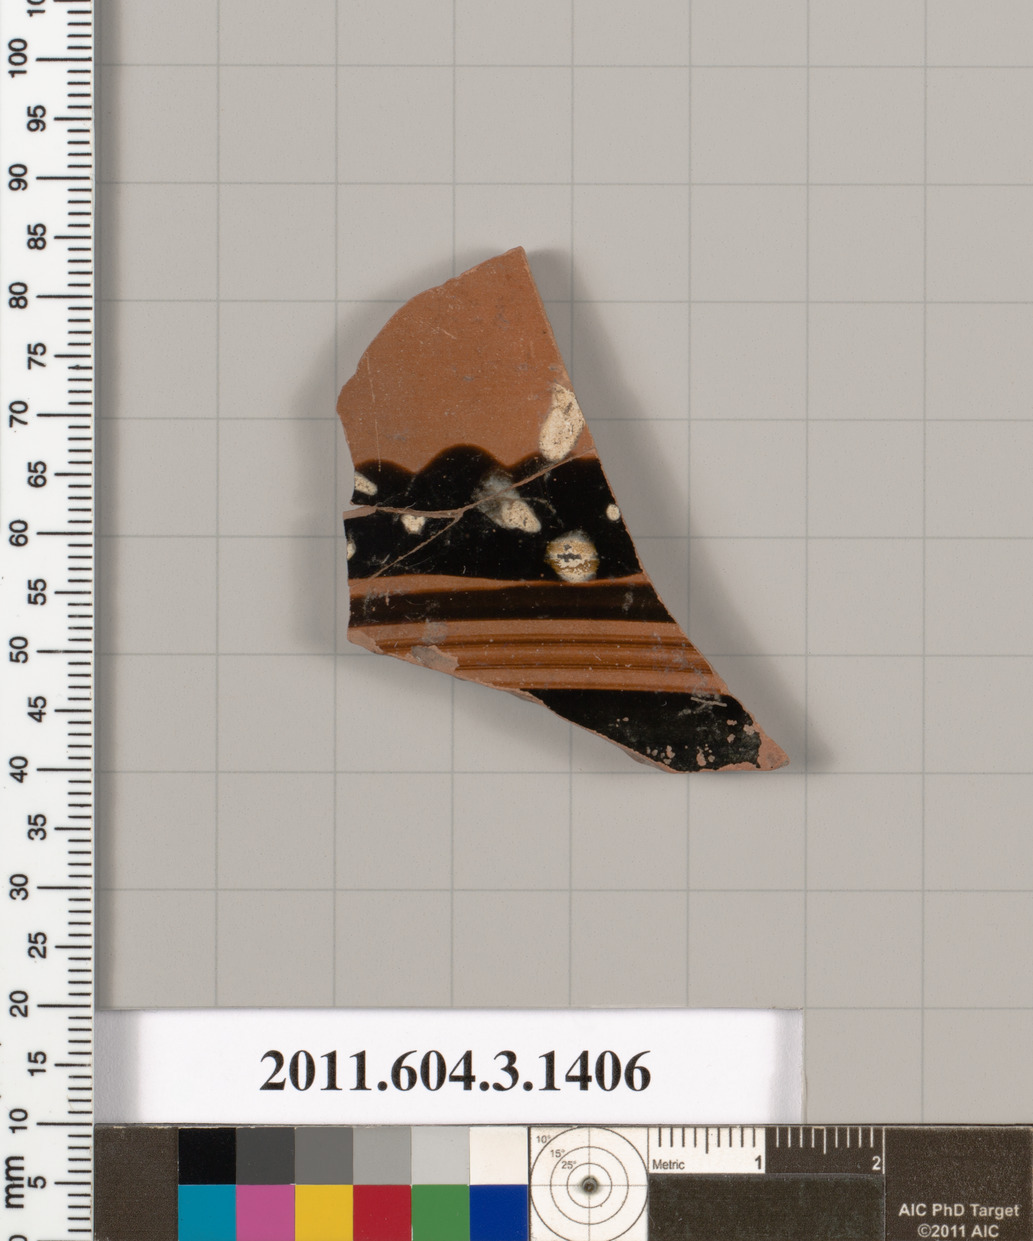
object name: skyphos fragment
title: Terracotta fragment of a skyphos (deep drinking cup)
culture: greek, attic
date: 534-468 BCE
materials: terracotta